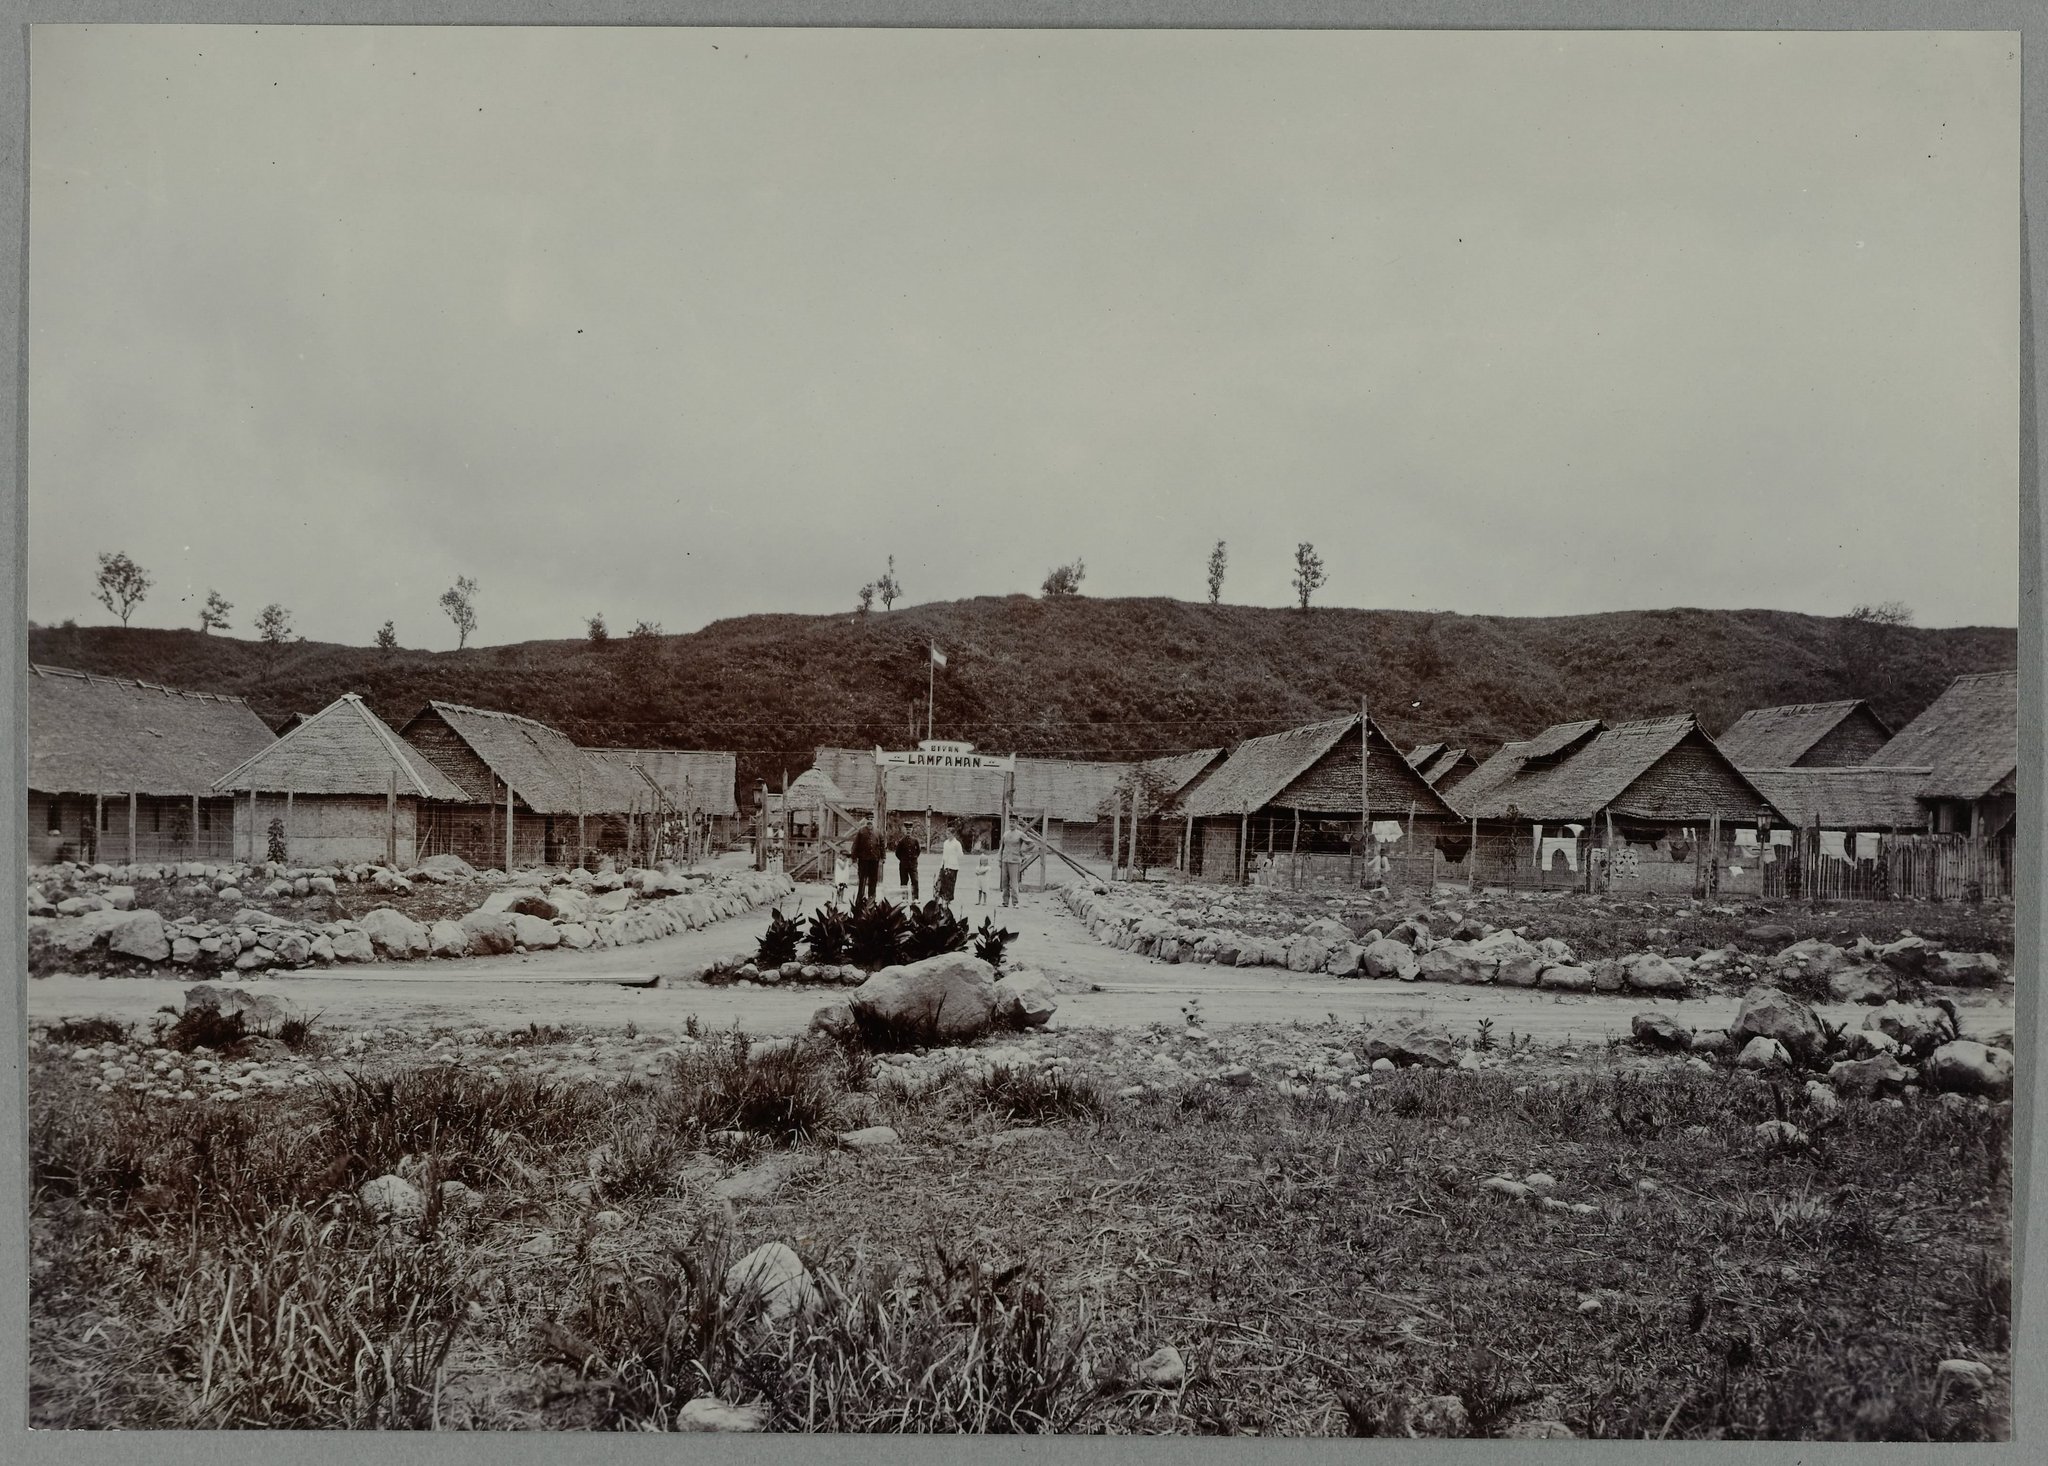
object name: photograph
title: Bivak Lampahan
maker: Anonymous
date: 1903-1913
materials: photographic support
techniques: photography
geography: north sumatra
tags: arnhem, the hague, albertus dominicus laman trip, traffic by road or path with motor-vehicle, landscapes in tropical and sub-tropical regions, village, road, path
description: Na de expedities naar de Gajo- en Alaslanden o.l.v. Van Daalen (eerste tocht in 1901), werd hij in 1903 belast met voorbereiding van permanente vestiging van Nederlands gezag. Aanleg van een weg van de Noordkust naar het binnenland was hierbij van groot belang. Deze zgn. Gajoweg werd aangelegd tussen 1903 en 1914, van Bireuen aan de kust naar Takinguen aan het bergmeer Danau Lauttawar, totale lente 104 km.